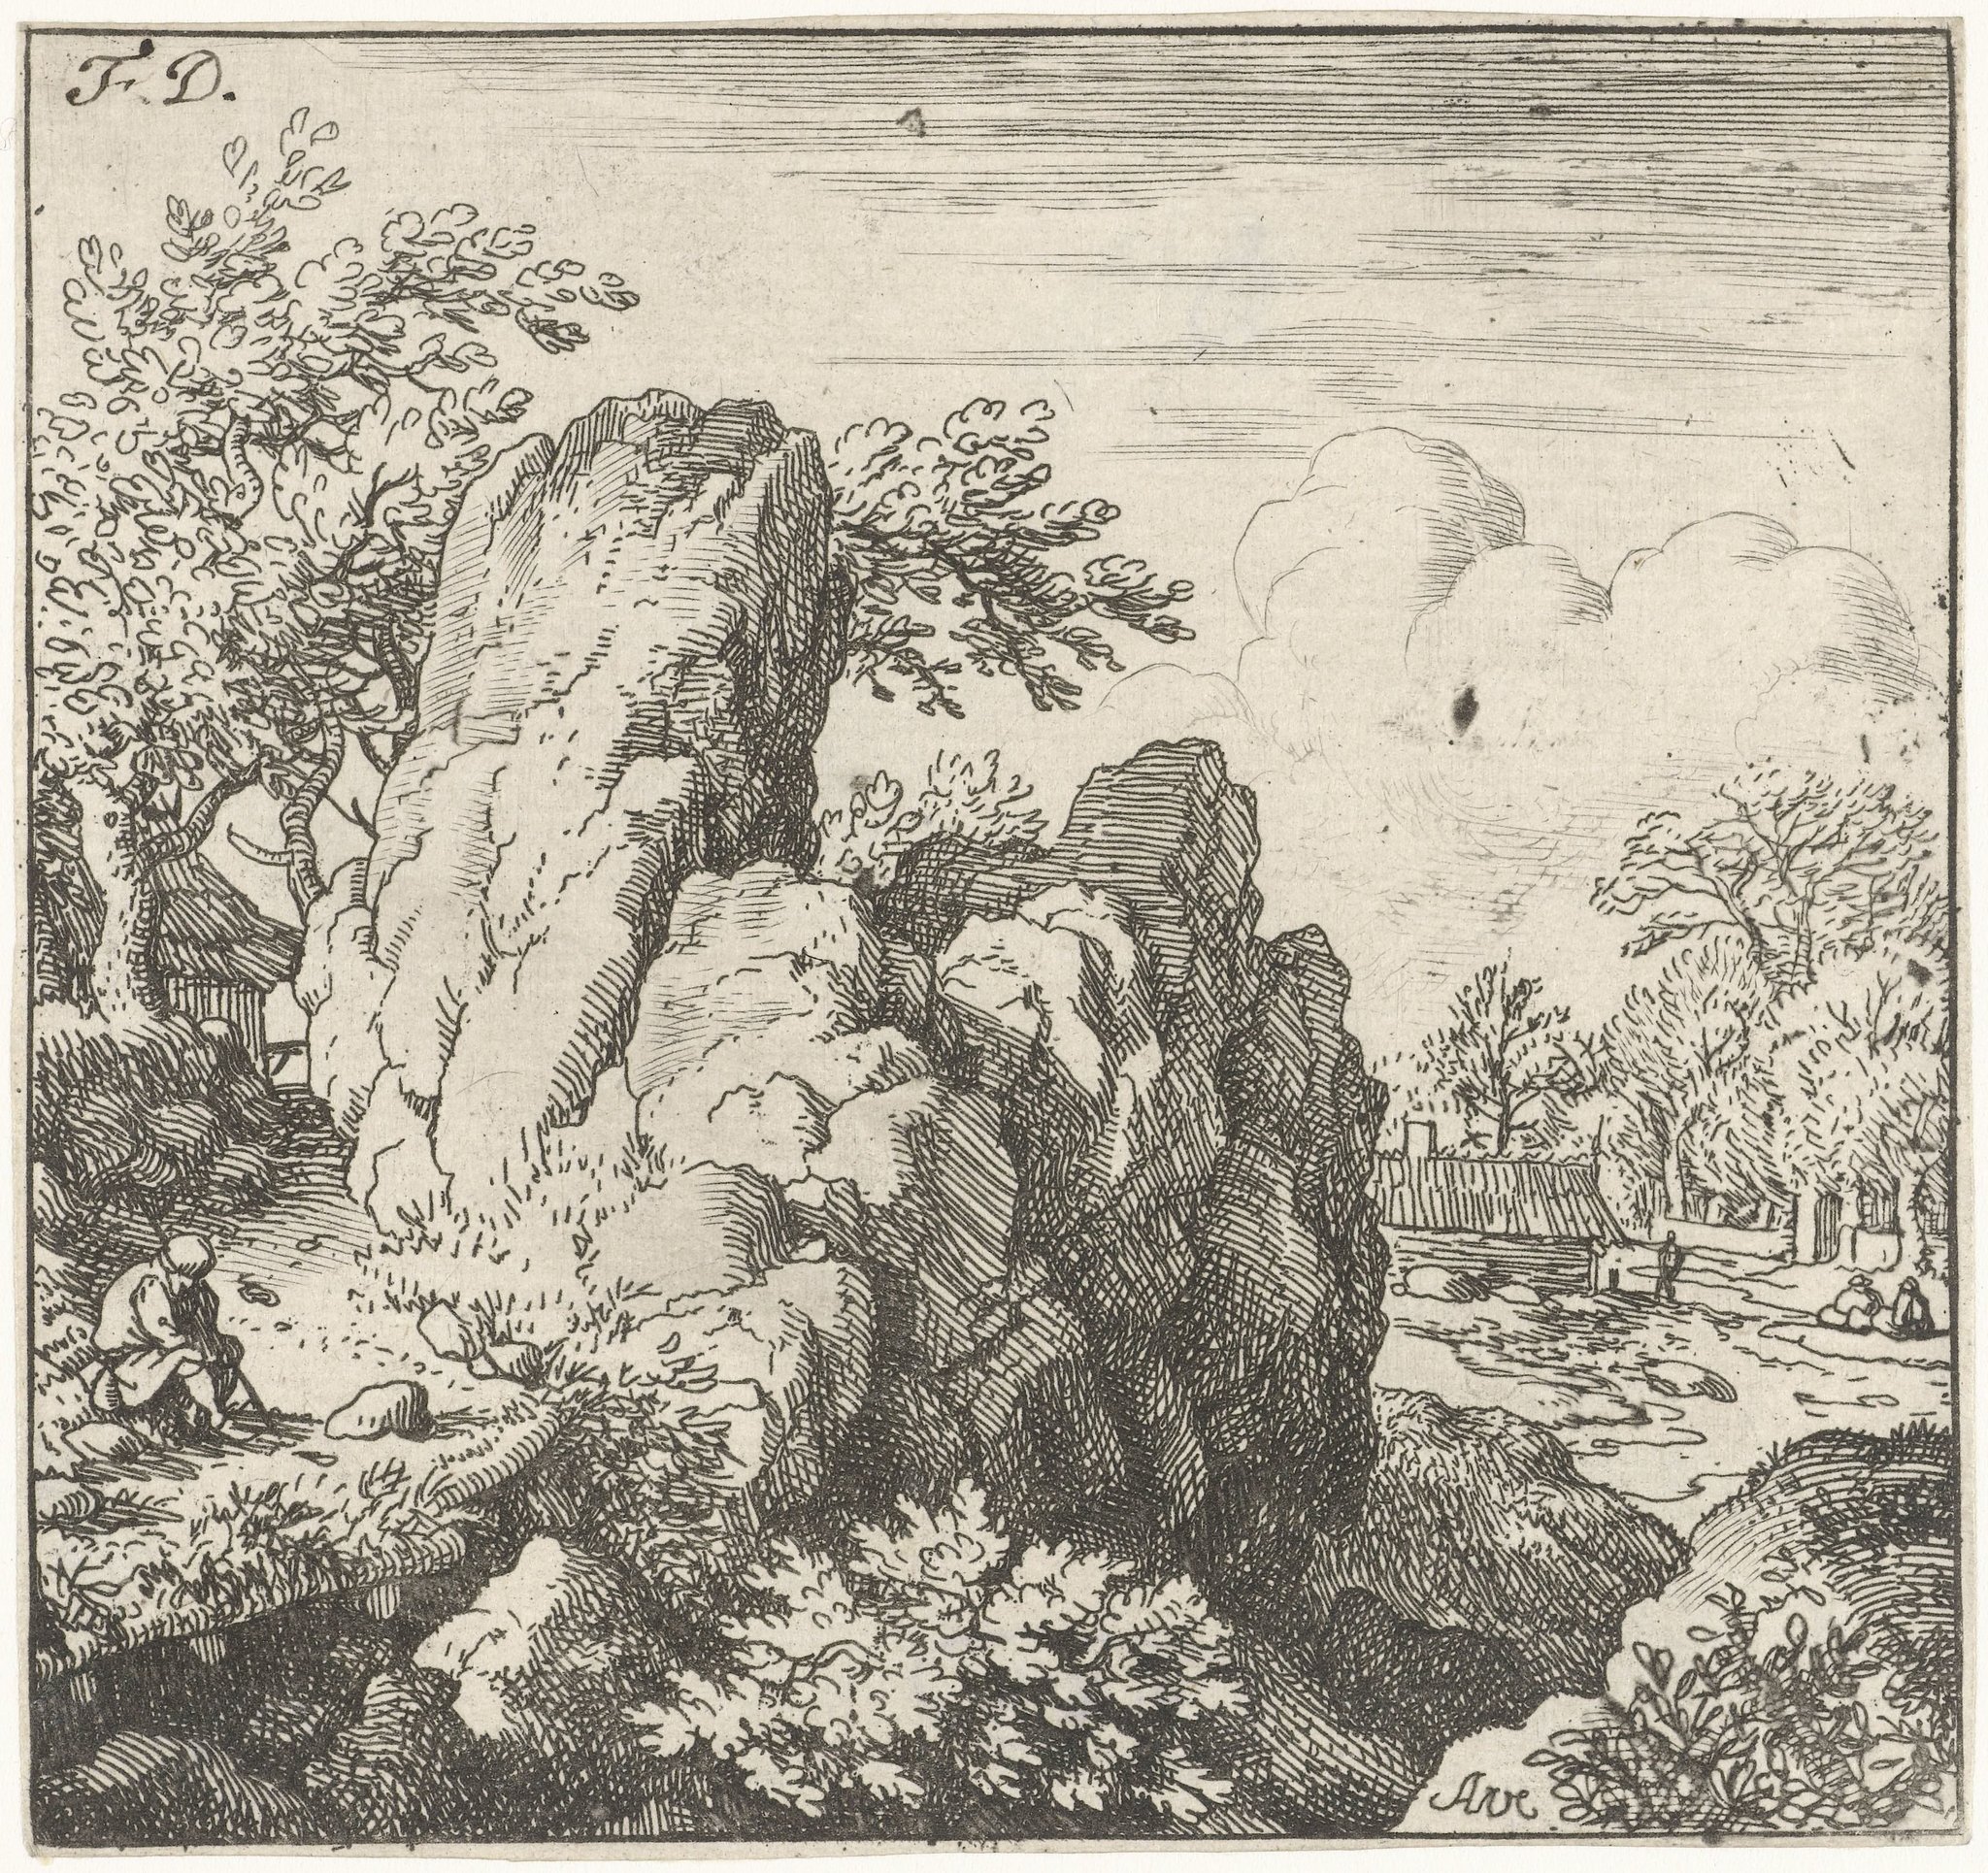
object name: print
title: Landschap met grote rots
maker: allaert van everdingen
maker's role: draughtsman, painter, print maker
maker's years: 1621-1675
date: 1631-1675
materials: paper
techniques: drypoint, etching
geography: netherlands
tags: rock-formations (+ landscape with figures, staffage)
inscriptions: collector's mark: Lugt 2228, initials: ‘F.D.’, collector's mark: Lugt 1407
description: Gezicht op een grote rotspartij en een zittende man op het pad ernaast. Op de achtergrond tussen de bomen en op de lager gelegen vlakte een huis.